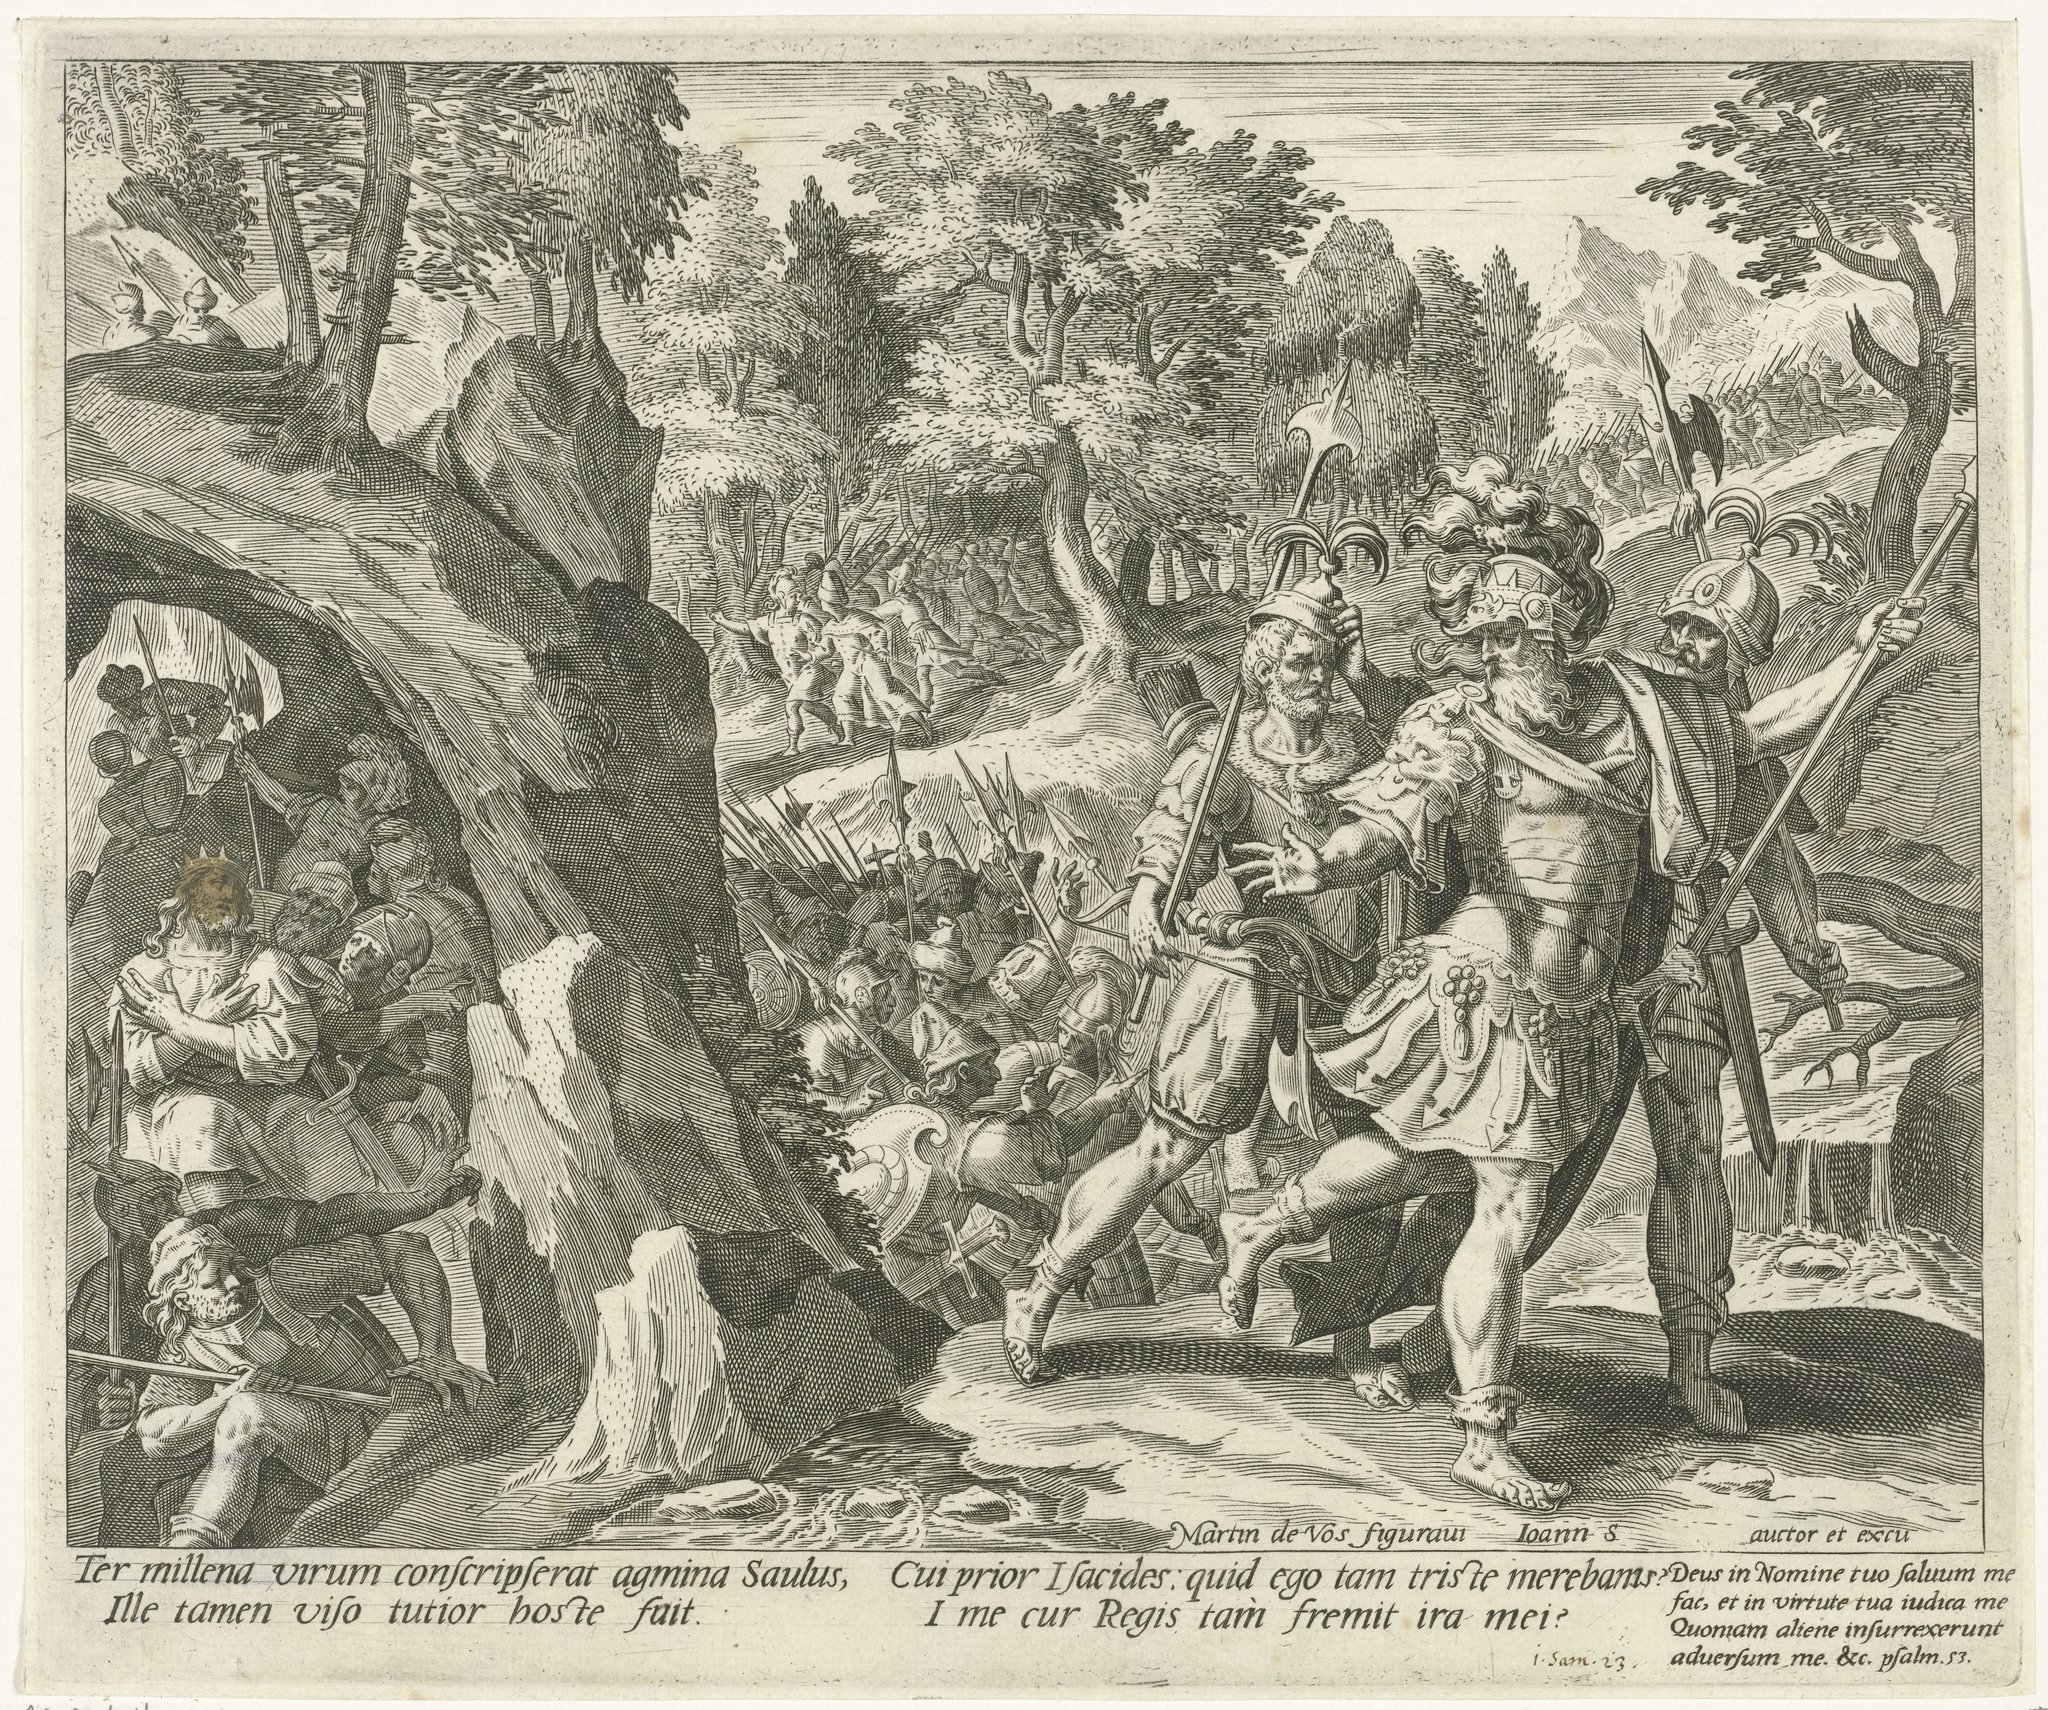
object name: print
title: David verschuilt zich voor het leger van Saul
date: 1580-1596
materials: paper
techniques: engraving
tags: david surrounded by saul and his men in the wilderness of maon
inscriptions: inscription: ‘1 Sam. 23’, collector's mark: Lugt 11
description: Saul zoekt in de wildernis van Zif met zijn leger naar David. Linksvoor zitten David en zijn manschappen verscholen in een grot. De prent heeft een Latijns onderschrift met uitleg en rechts in de hoek een vers uit psalm 53.